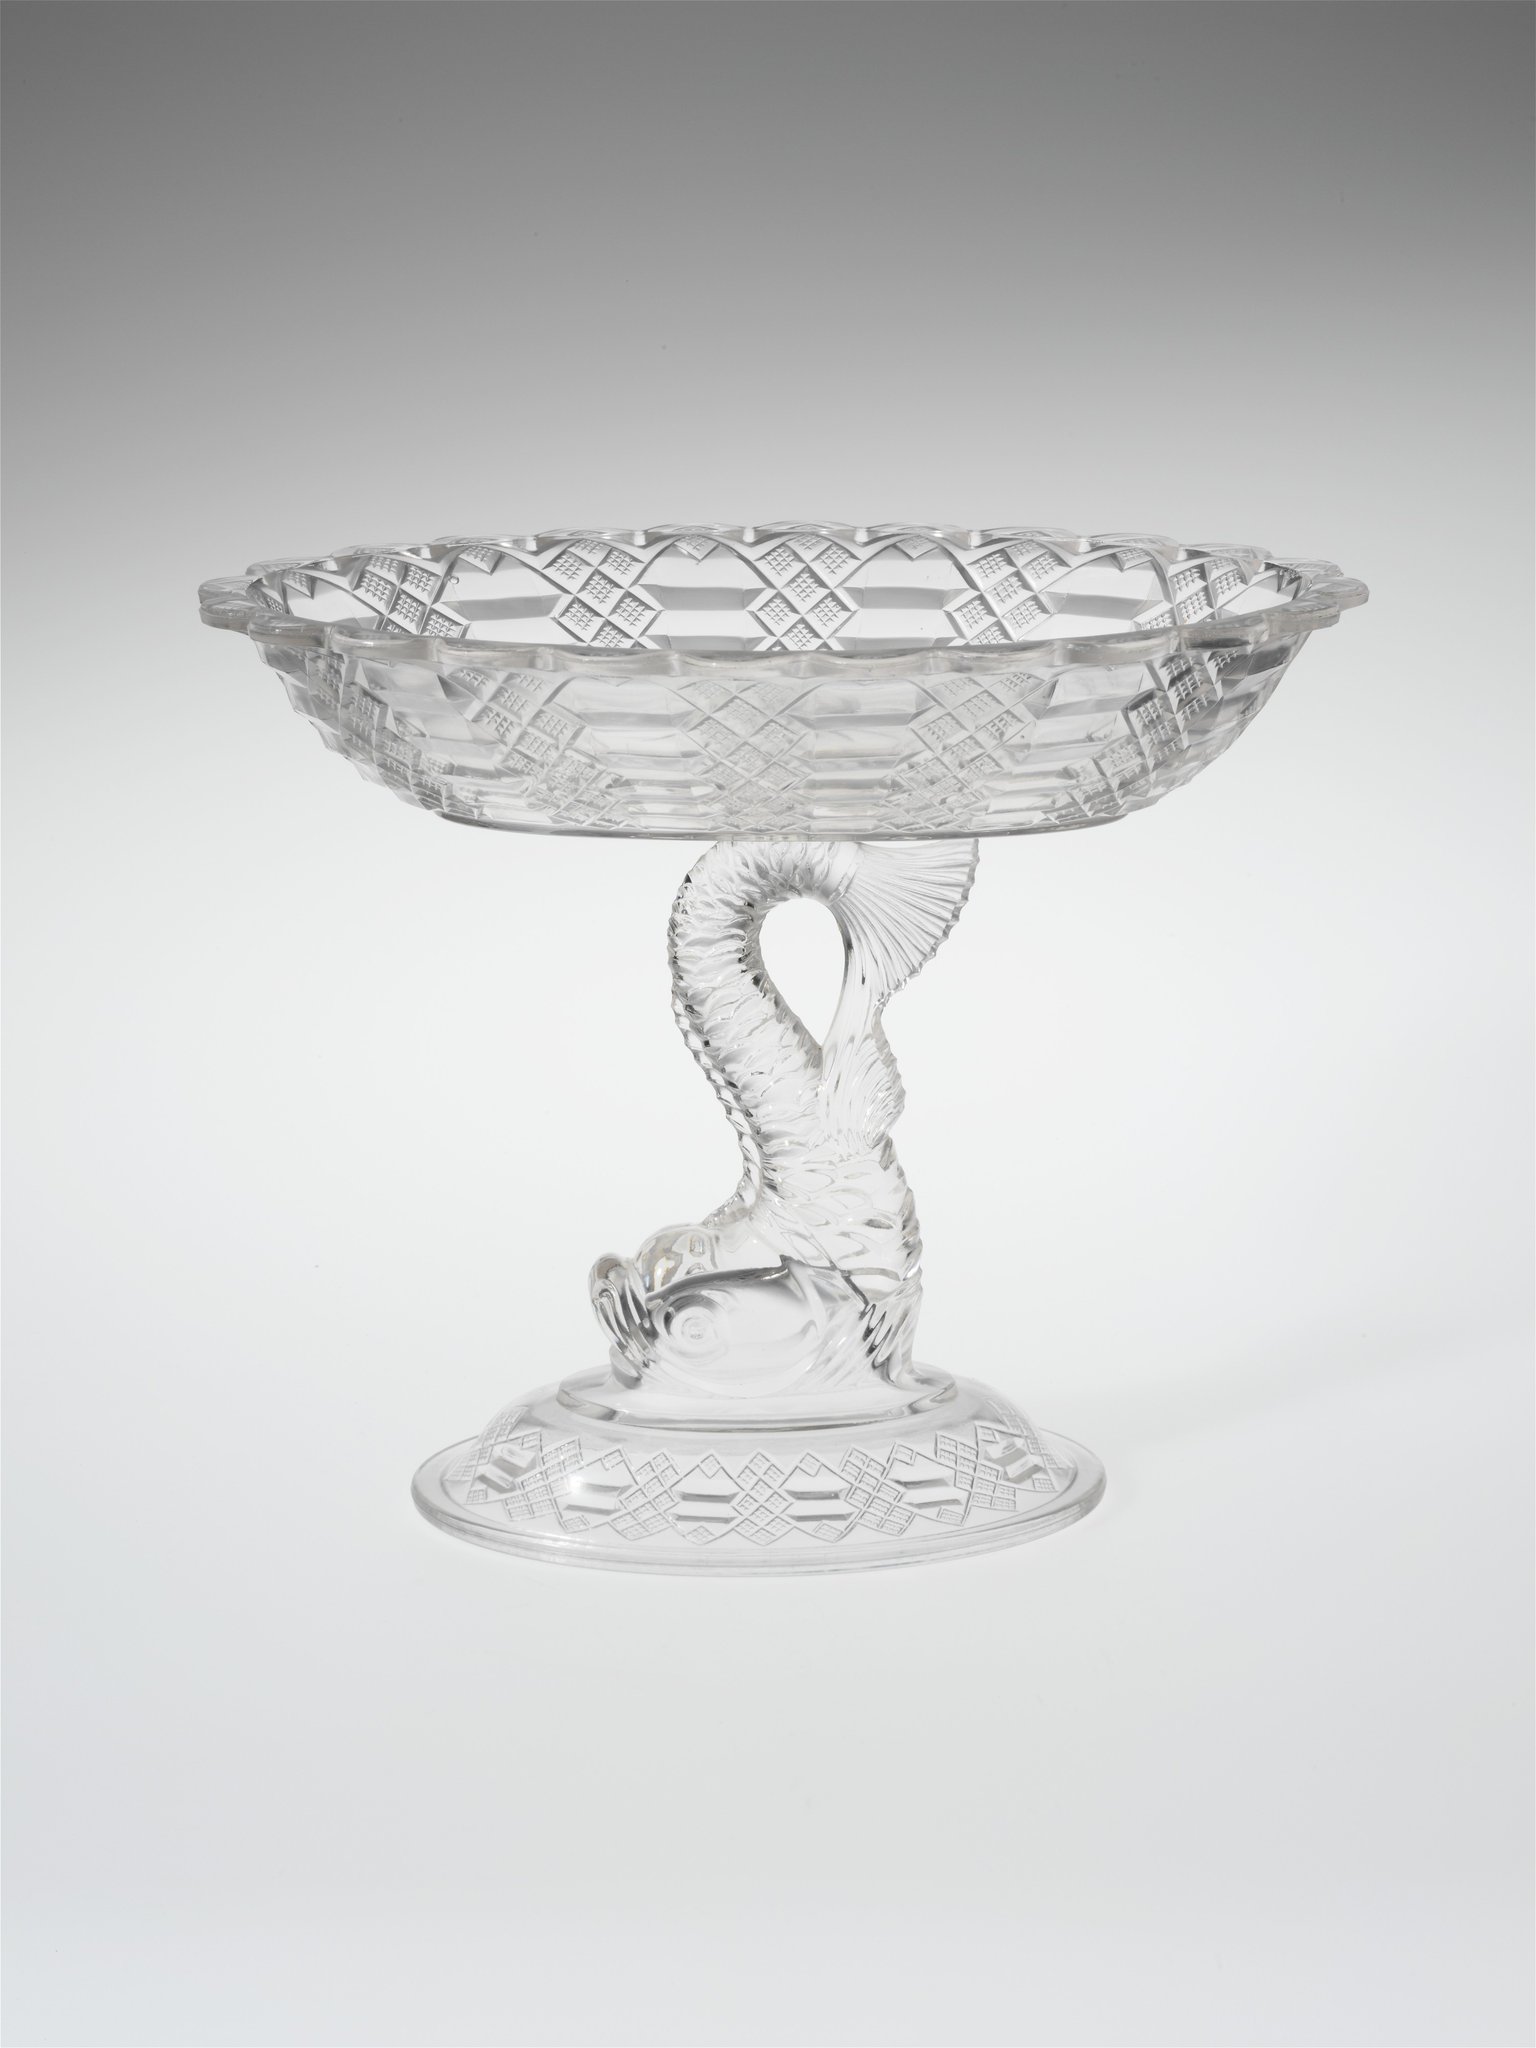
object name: compote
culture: american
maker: bryce brothers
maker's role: maker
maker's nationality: american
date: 1876-1885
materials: glass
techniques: pressed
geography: united states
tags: dolphins